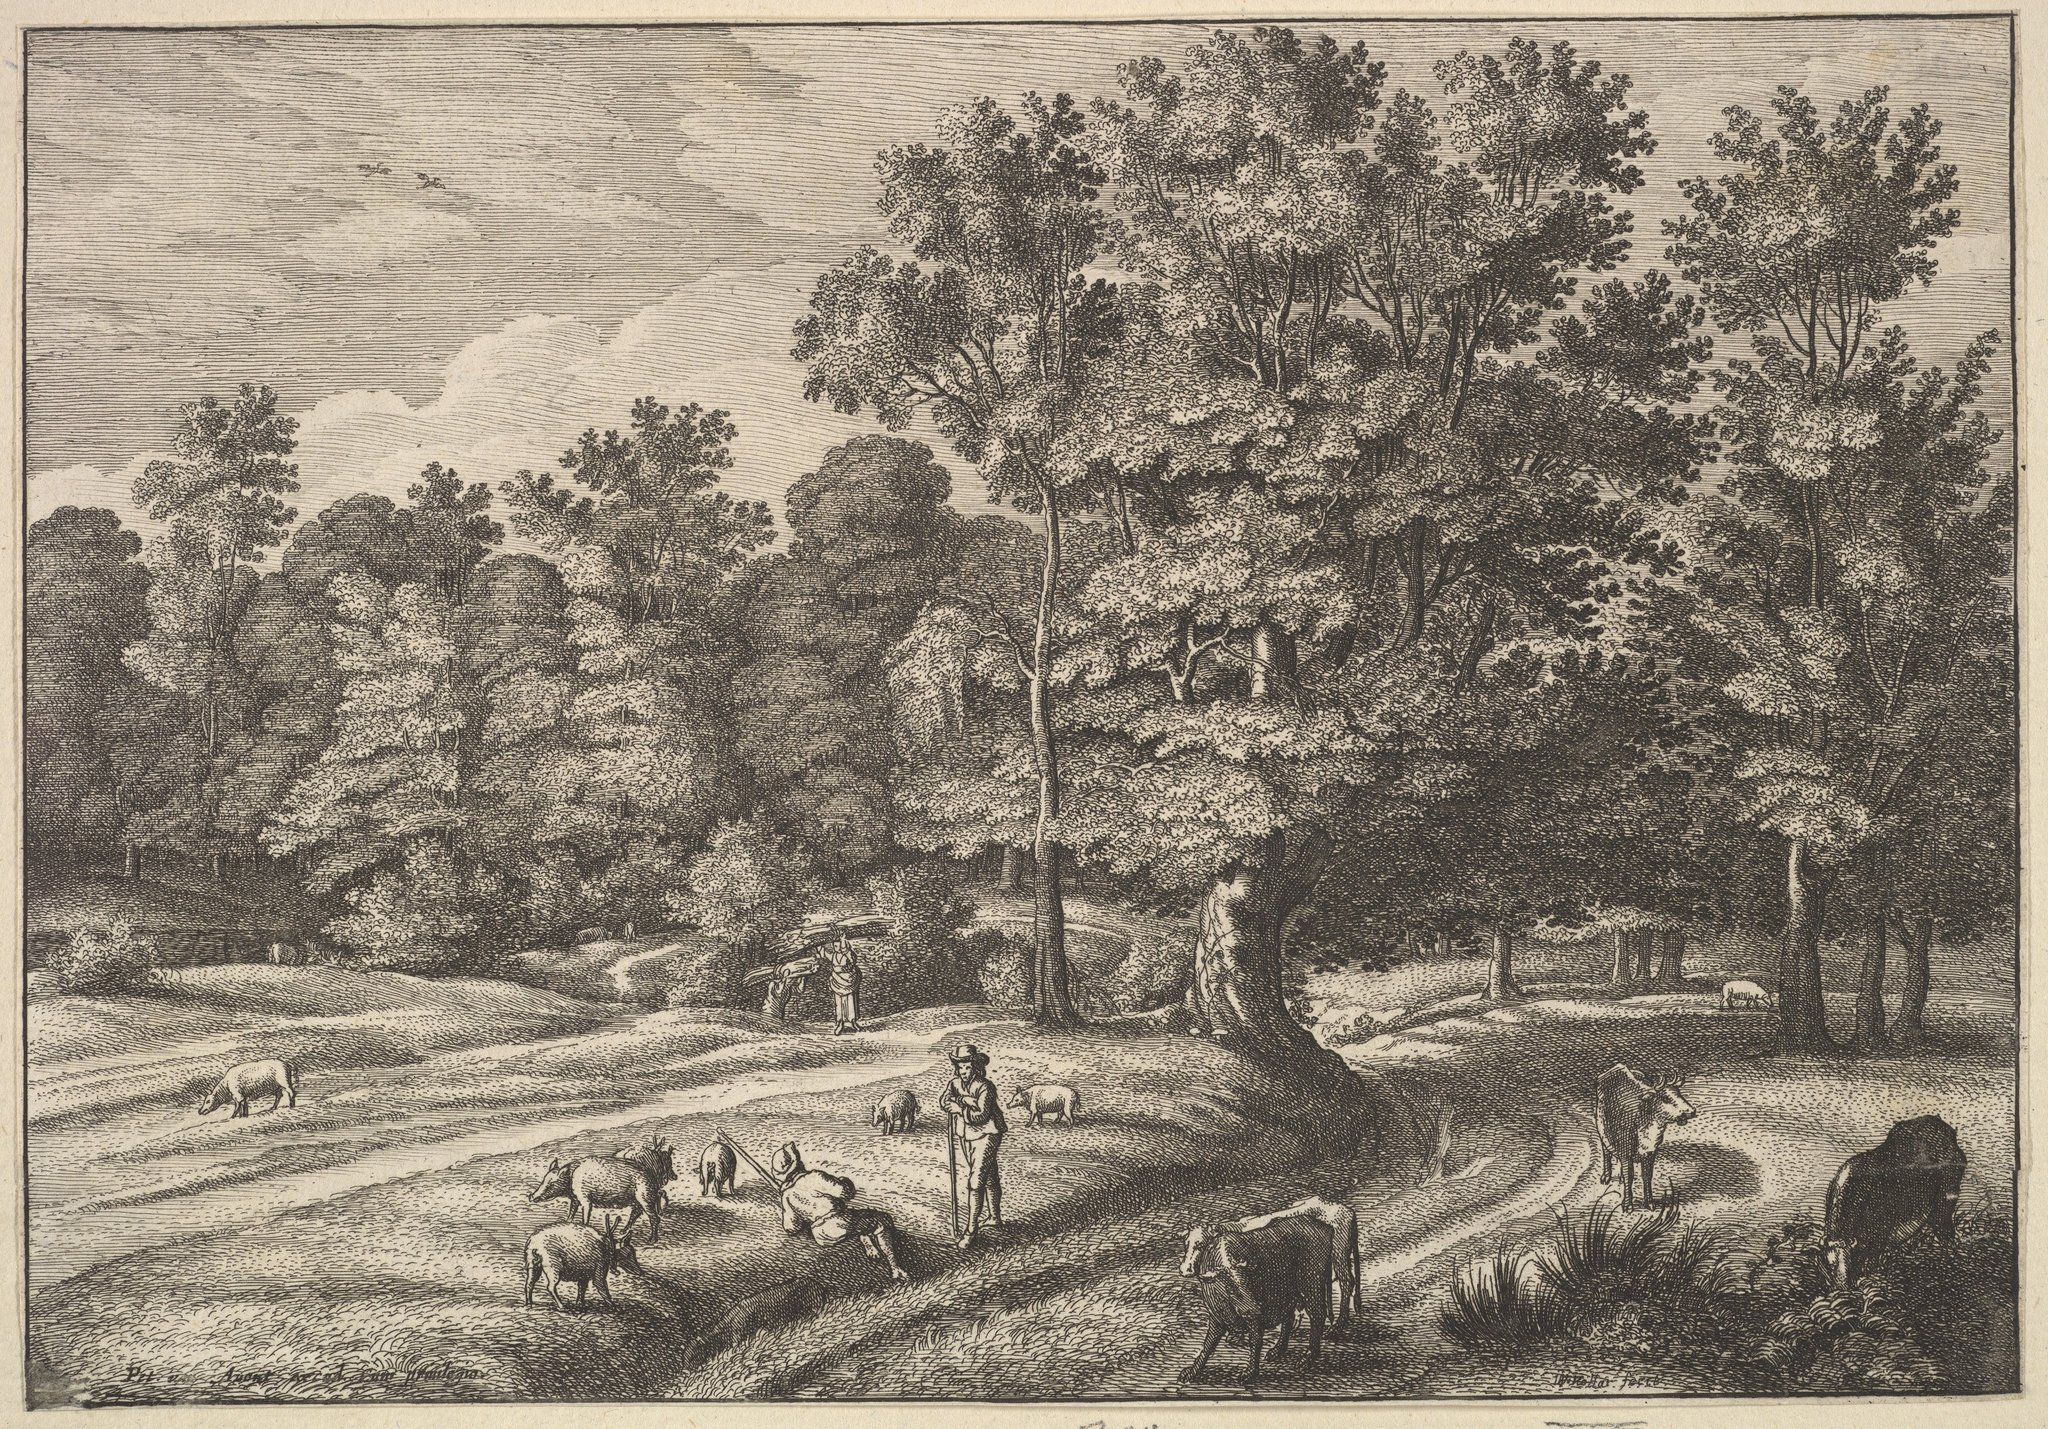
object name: print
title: Pigherder and Cowherd Conversing in a Clearing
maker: wenceslaus hollar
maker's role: artist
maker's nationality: bohemian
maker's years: 1607-1677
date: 1648-1650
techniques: etching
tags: cows,forests,shepherds